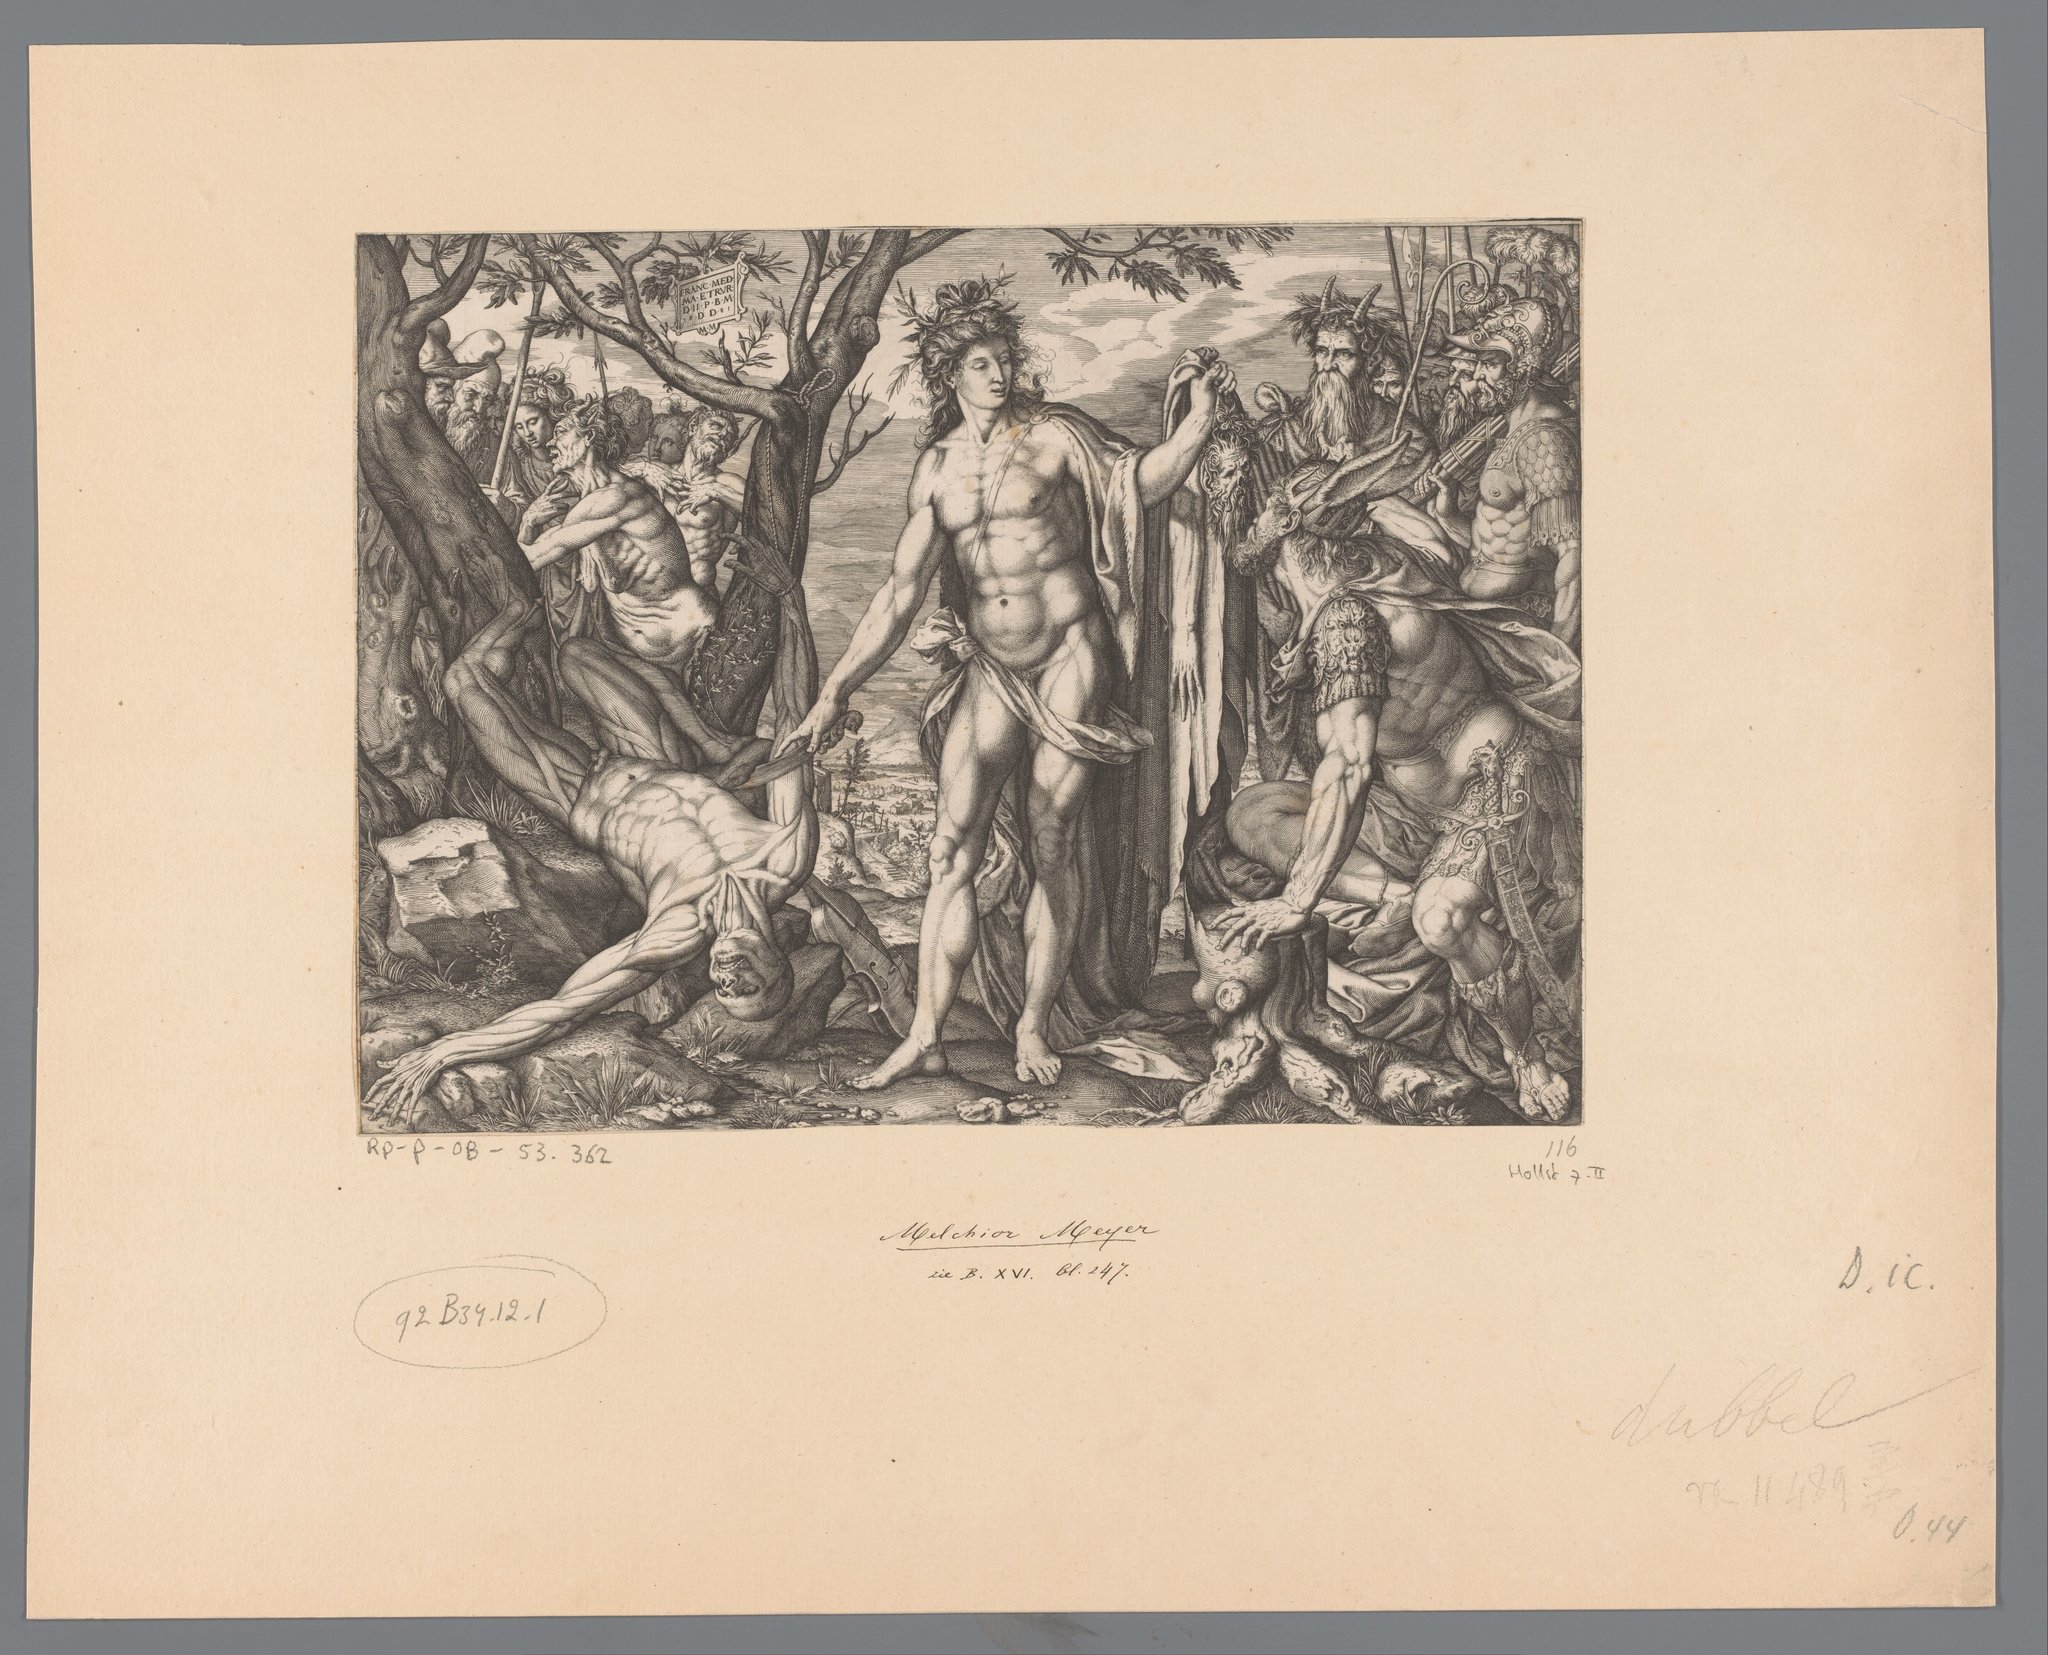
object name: print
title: Apollo en Marsyas en het oordeel van Midas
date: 1581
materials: paper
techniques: engraving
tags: punishment of marsyas: he is flayed by apollo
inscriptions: collector's mark: Lugt 240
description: Apollo in het midden, met het mes in de hand waarmee zojuist Marsyas gevild is, wiens huid Apollo in zijn linker hand vast heeft. Marsyas zelf hangt zonder huid aan de boom. Rechts de knielende Midas met de ezelsoren, saters en soldaten in de achtergrond.